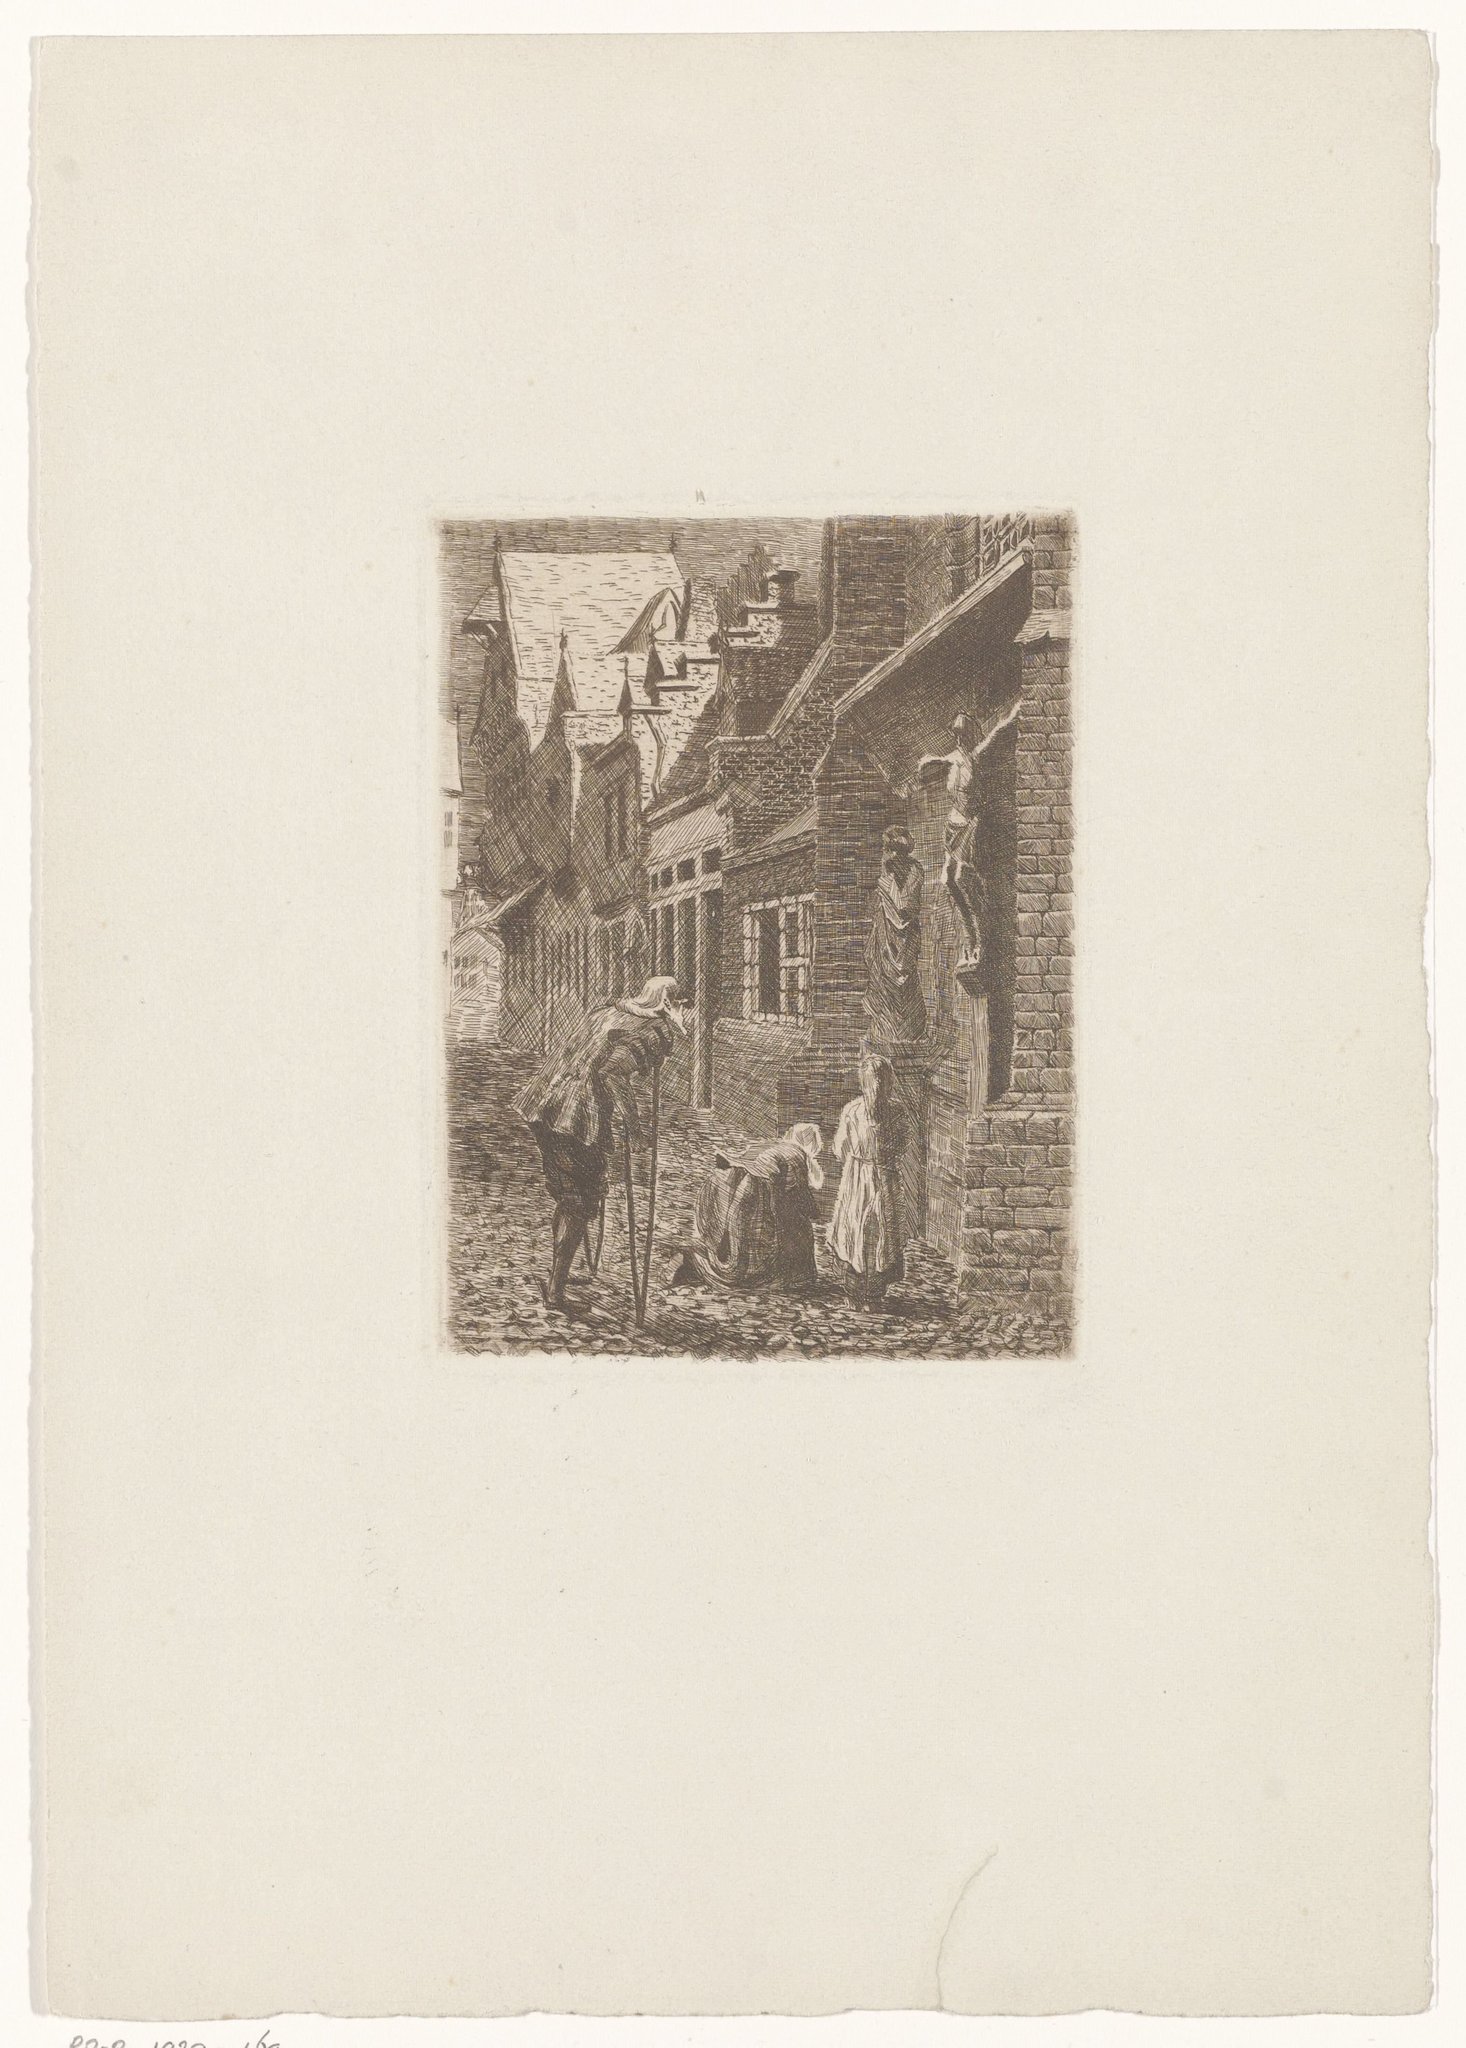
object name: print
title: Man met krukken, vrouw en kind bidden bij een crucifix in een straat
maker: Anonymous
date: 1800-1927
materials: paper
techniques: etching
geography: netherlands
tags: kneeling figure, street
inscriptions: collector's mark: Lugt 2233